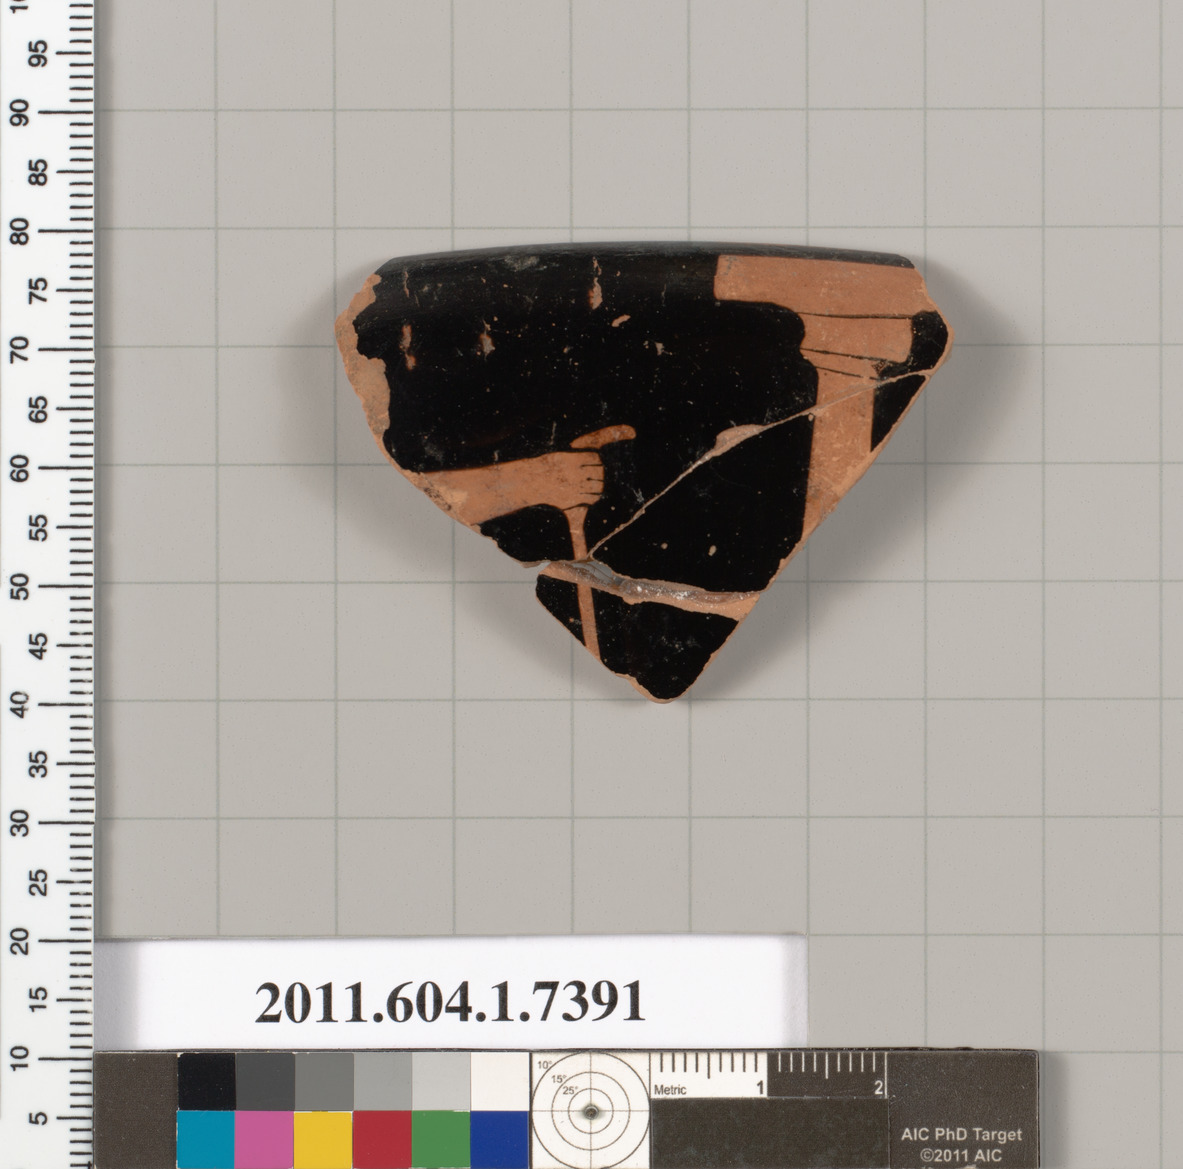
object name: kylix fragment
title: Terracotta rim fragment of a kylix (drinking cup)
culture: greek, attic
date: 500-480 BCE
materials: terracotta